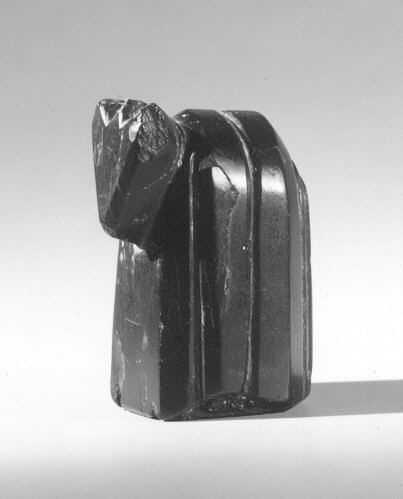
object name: chess piece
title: Chess Piece, Knight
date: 701-1000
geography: western islamic lands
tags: chess,games